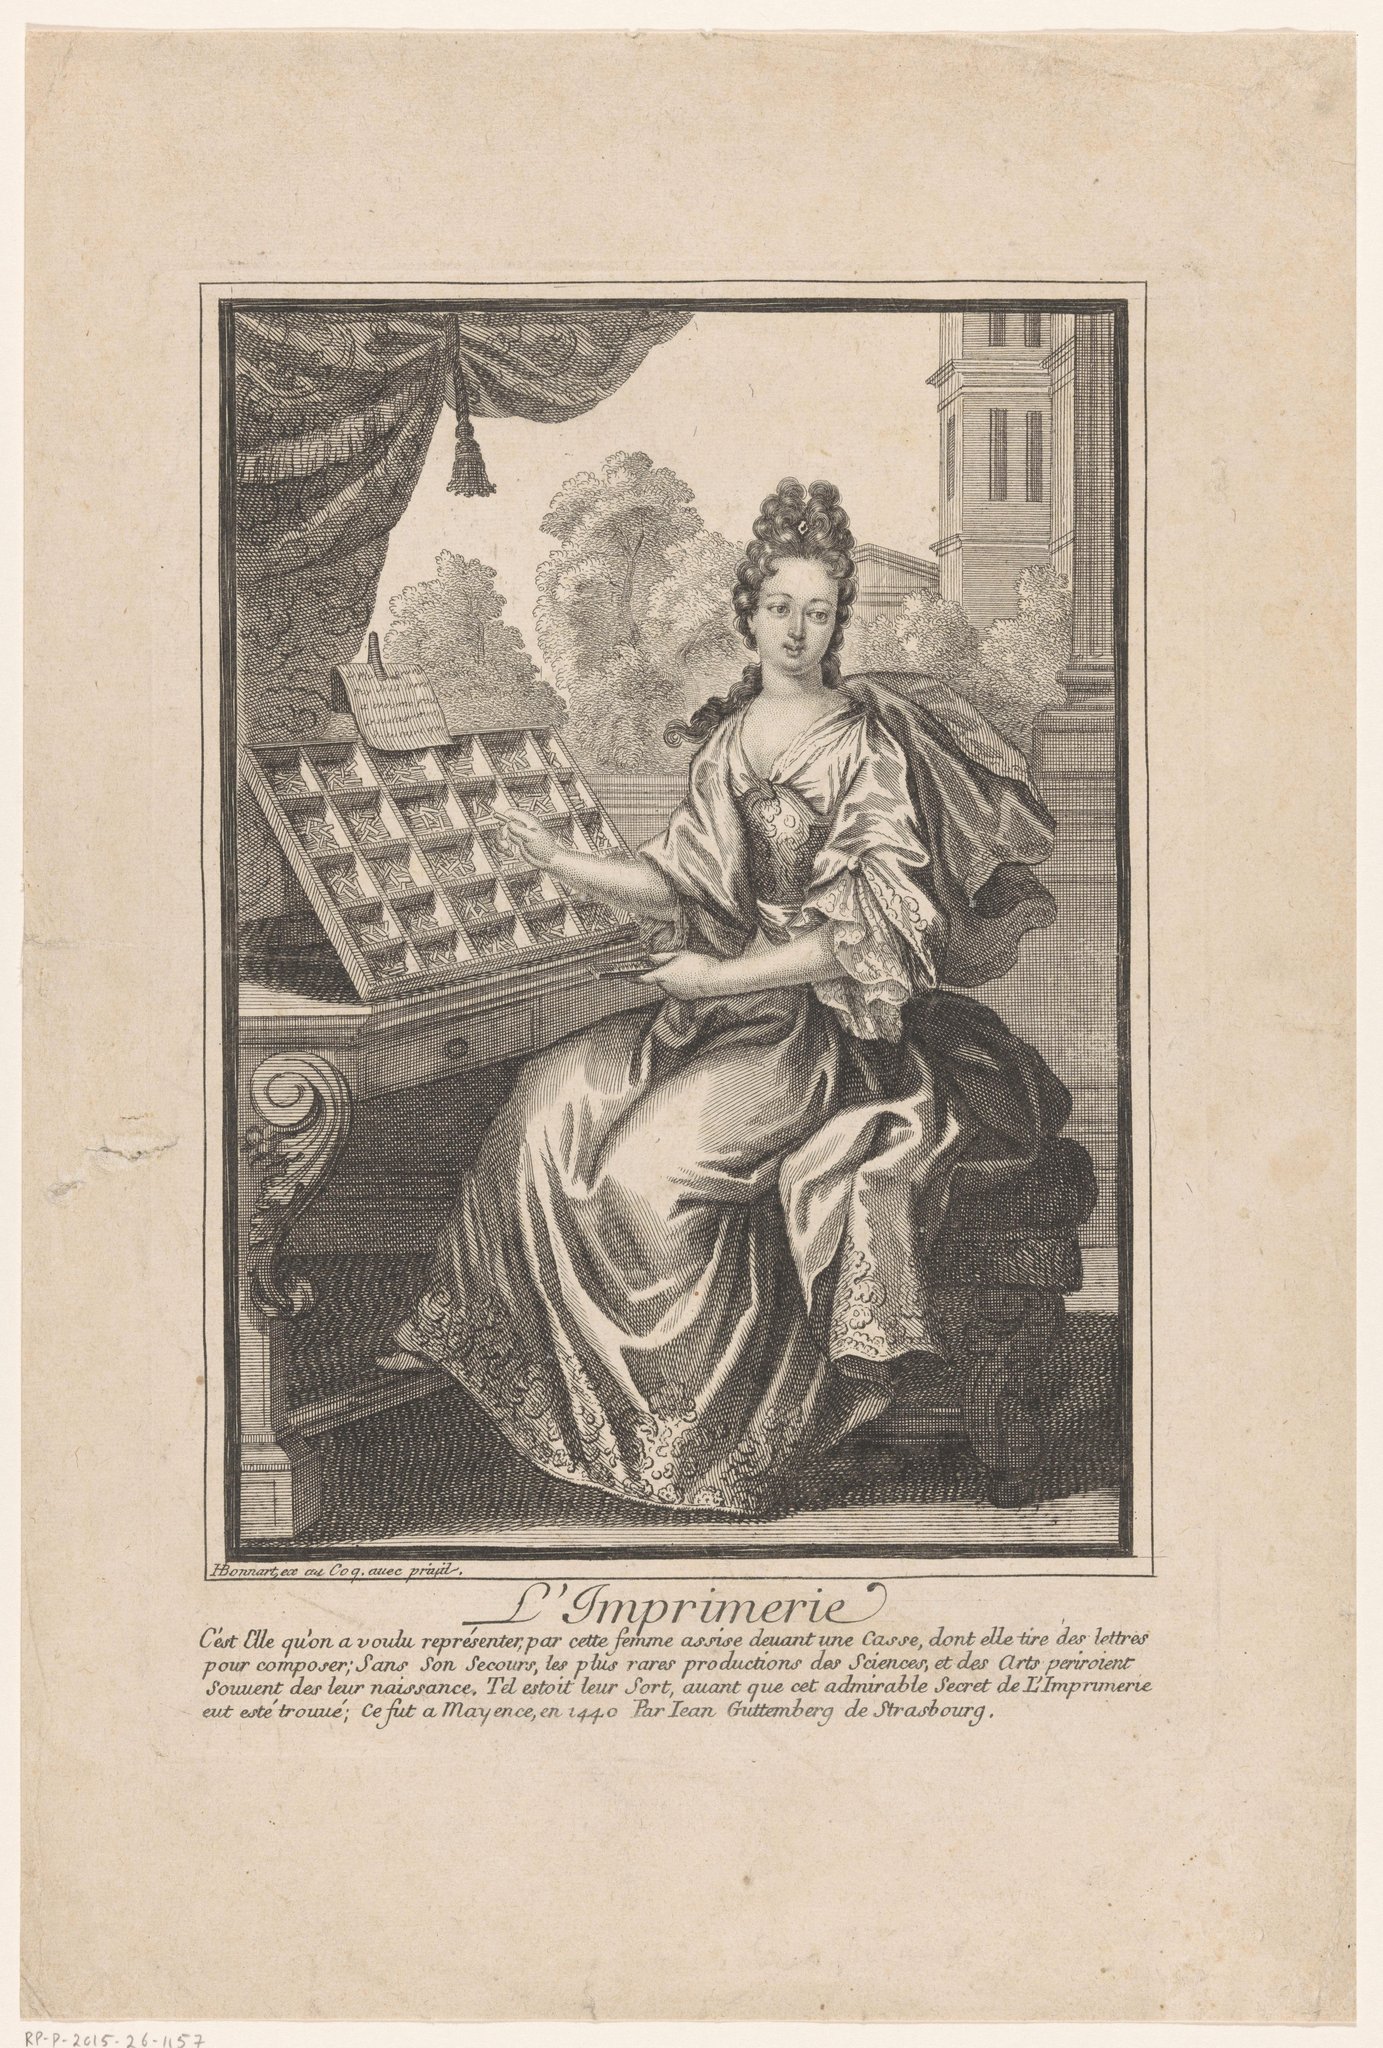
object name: print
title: L'imprimerie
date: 1654-1682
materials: paper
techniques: etching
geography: paris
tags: abstract ideas and concepts (+ clothed), tools, implements of printer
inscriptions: collector's mark: Lugt 2228, collector's mark: Lugt 4779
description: Een elegant geklede vrouw zit achter een bureau met daarop een letterkast waarop een tekst is bevestigd. In haar hand houdt ze een zetsel.